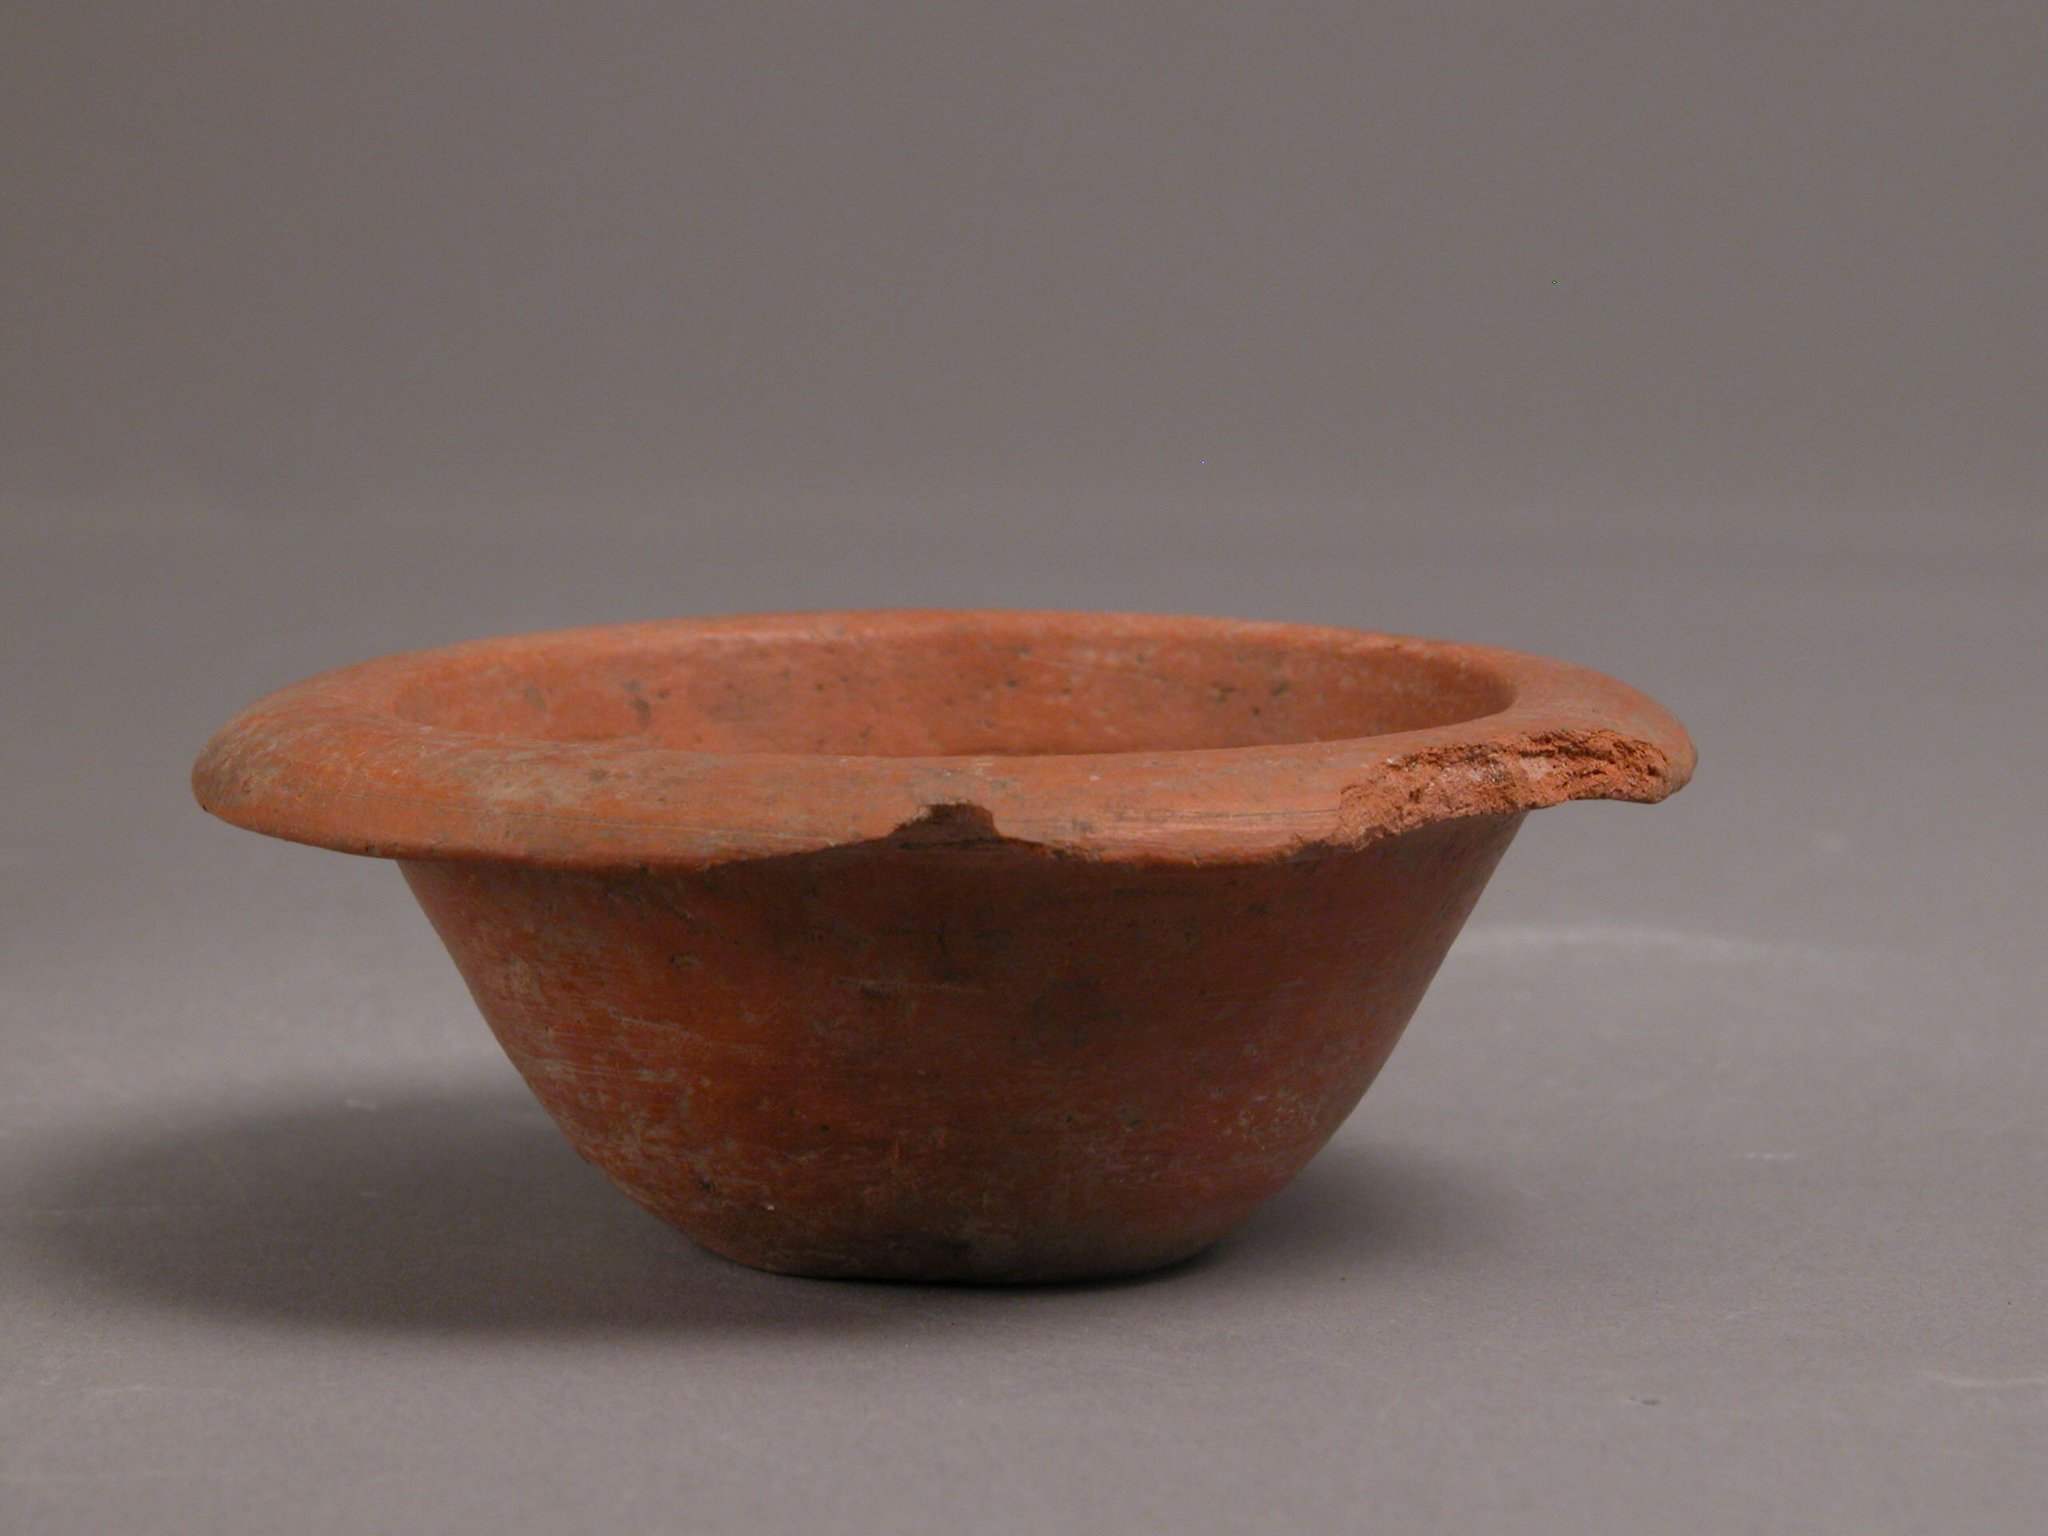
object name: bowl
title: Nesting Bowl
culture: coptic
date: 301-700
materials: earthenware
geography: egypt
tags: bowls